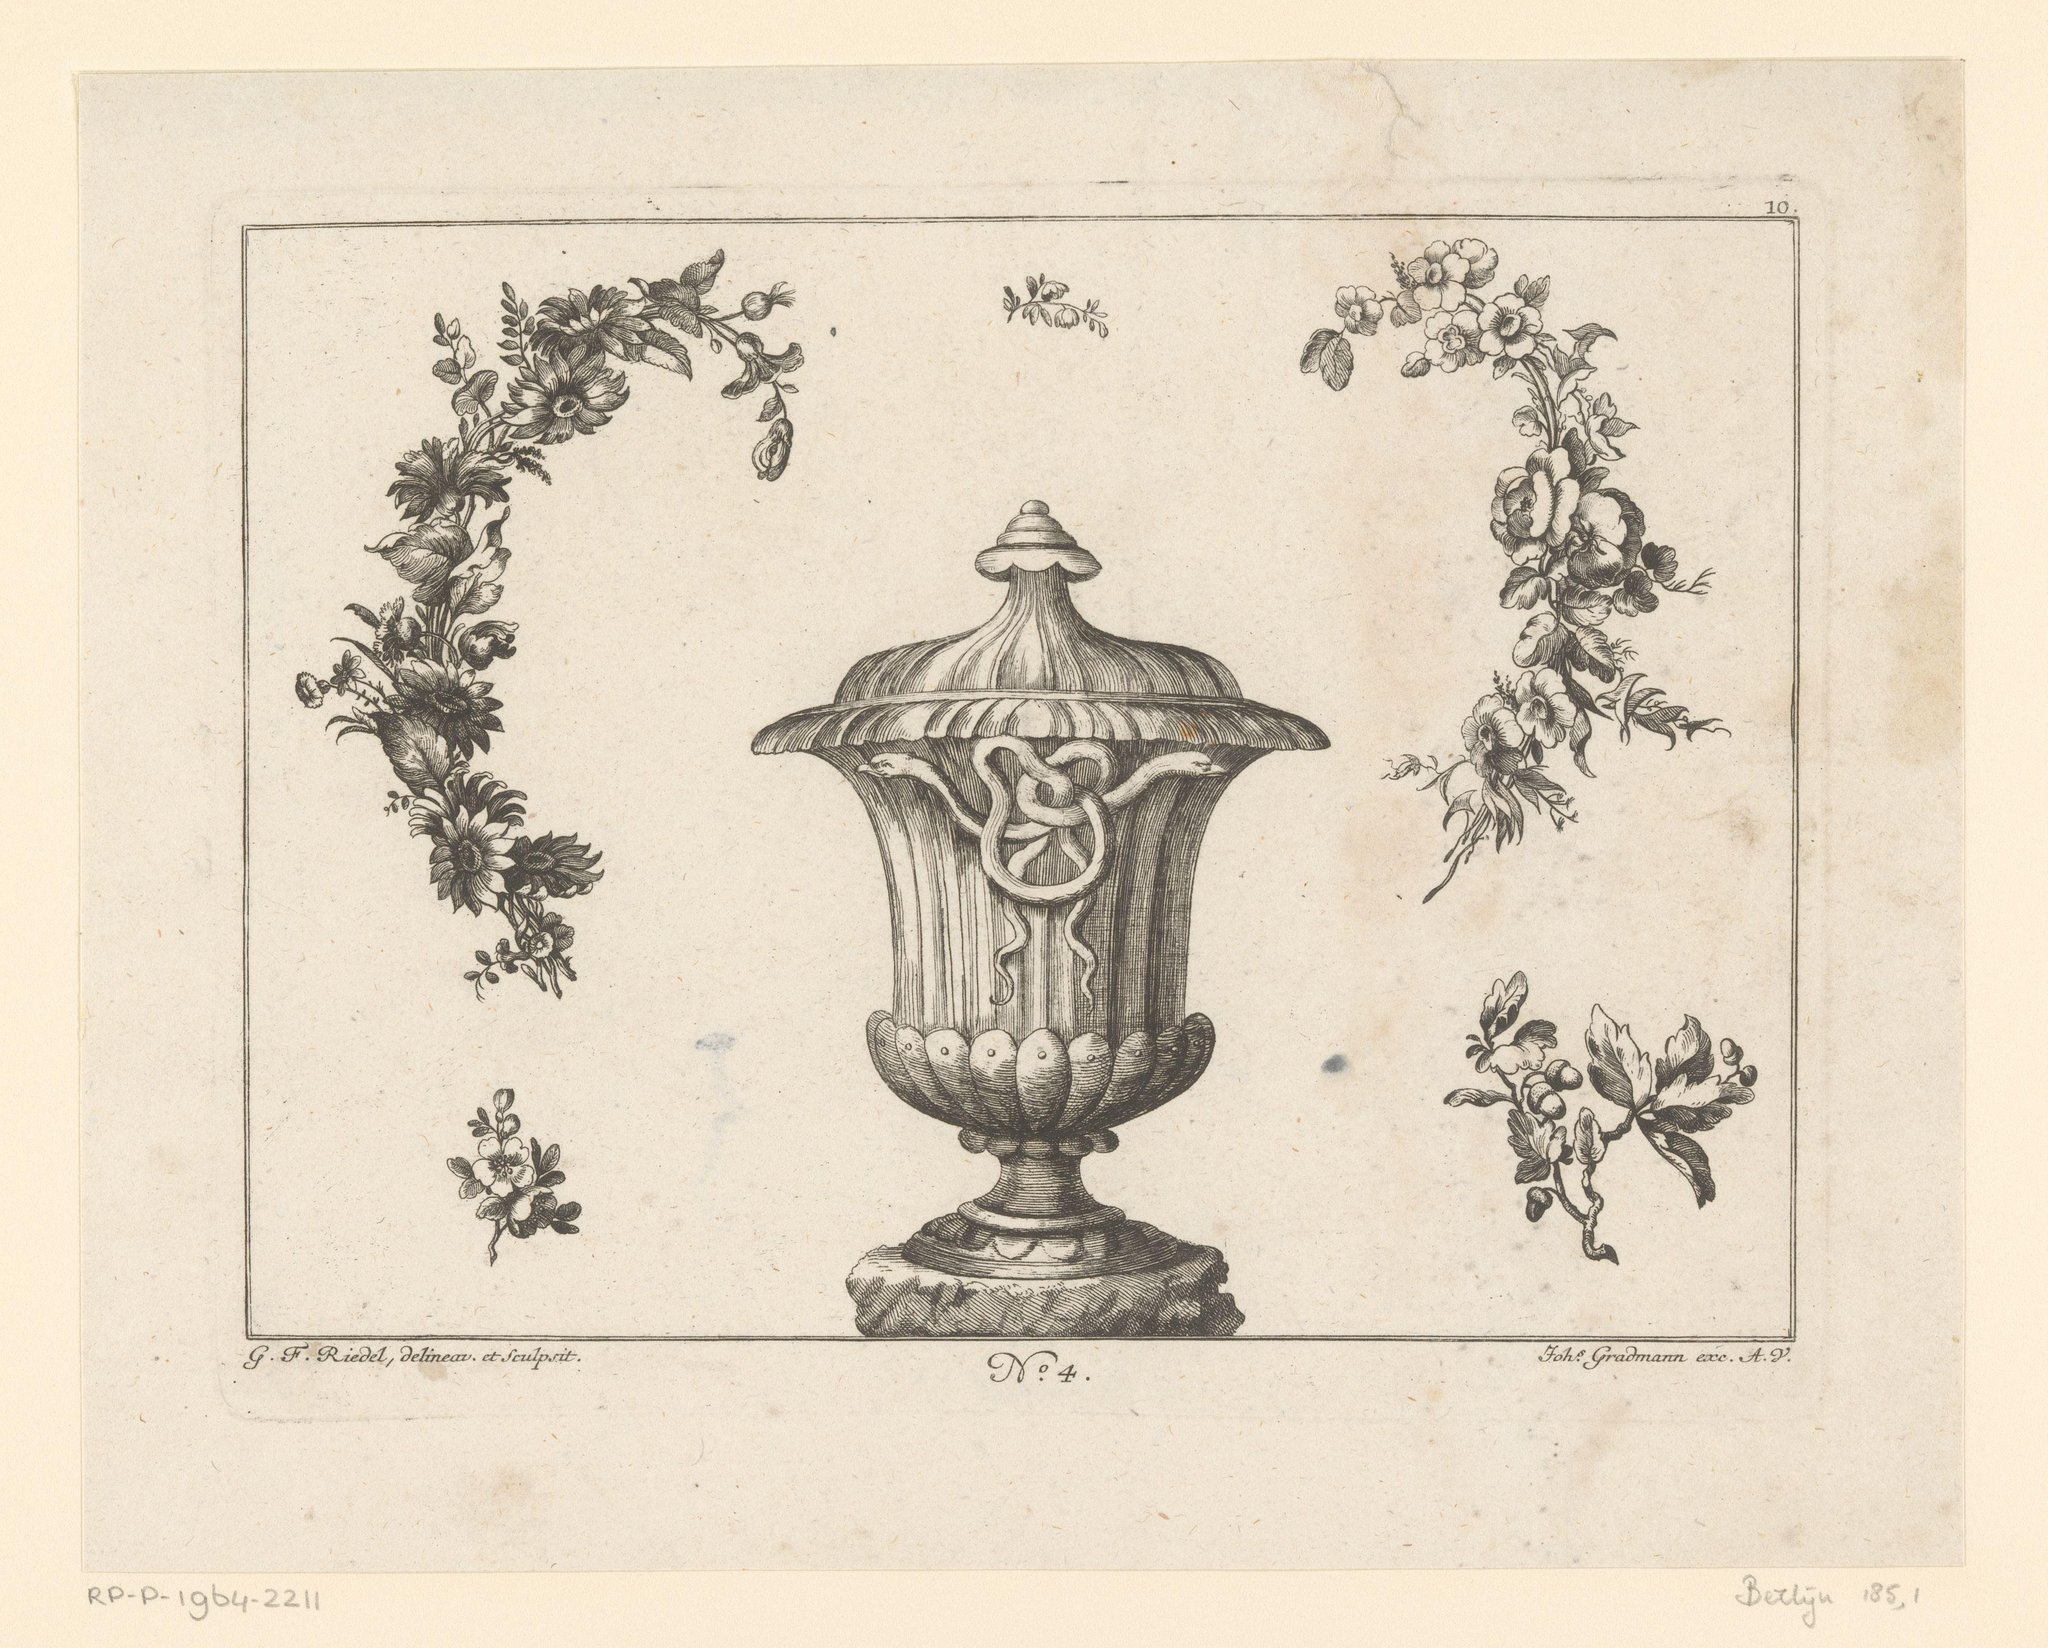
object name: ornament print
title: Samlung verschiedner Blumen, Früchte, gewohnlicher Zierathen (...)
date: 1778-1779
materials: paper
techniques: etching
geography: augsburg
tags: snakes, vase ~ ornament, flowers ~ ornament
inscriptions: collector's mark: Lugt 2228, collector's mark: Lugt 2760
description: Twee bloemenranken aan weerszijden van een vaas met in elkaar gevlochten slangen. Uitgeversnummer 4.